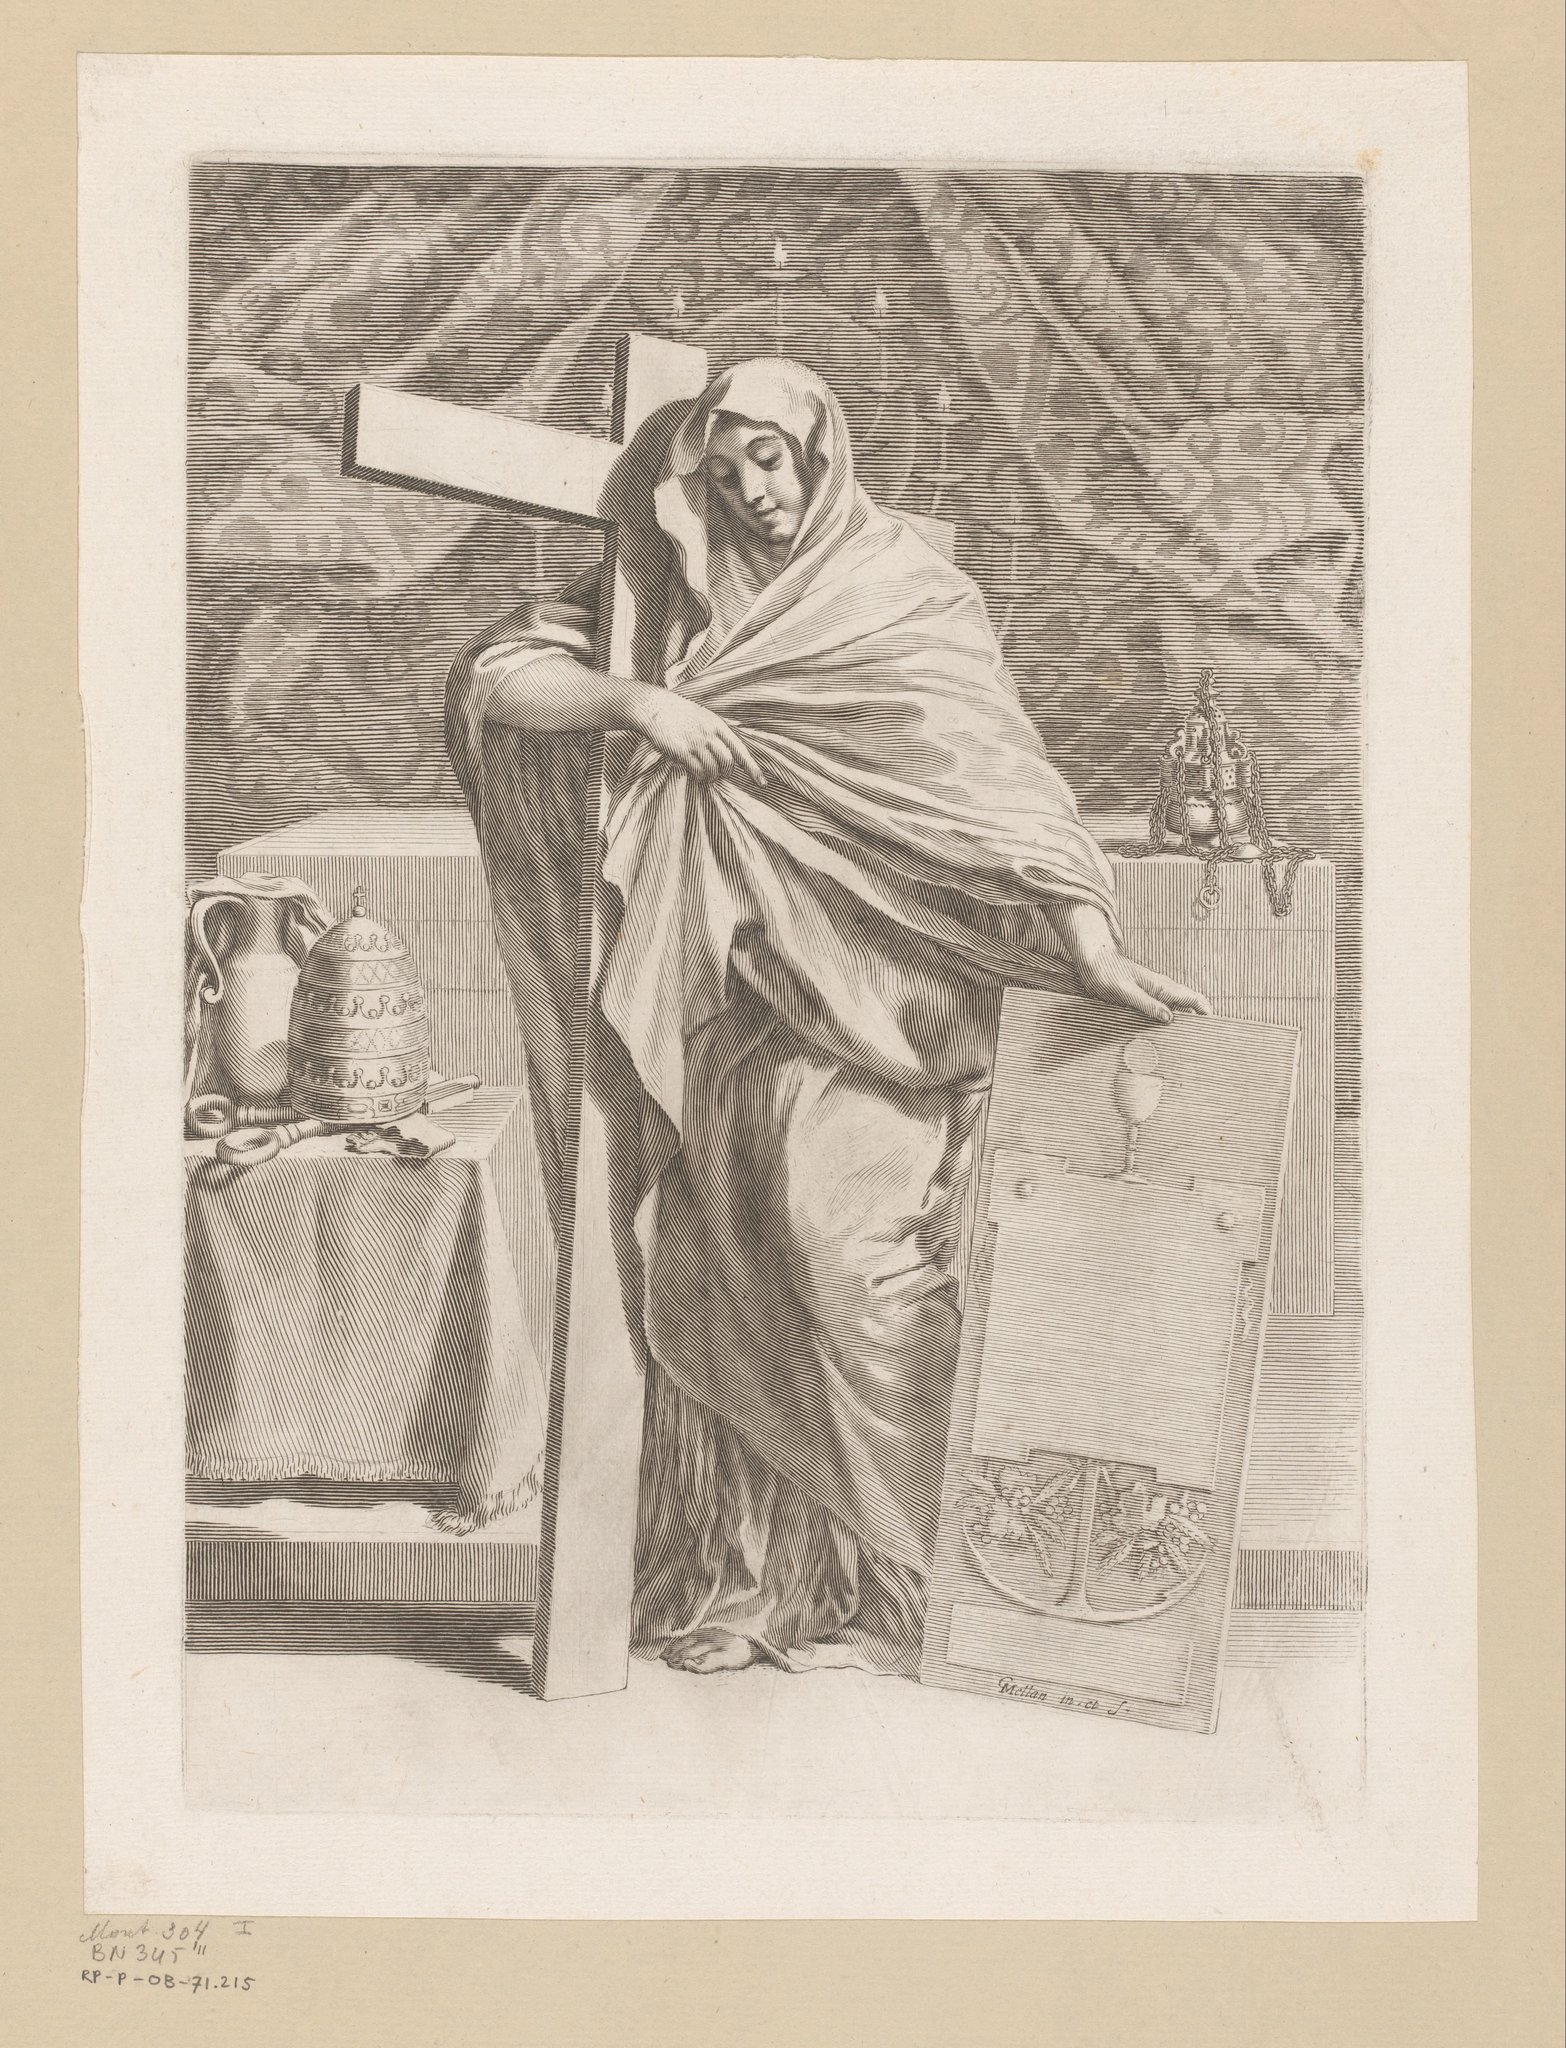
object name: titelblad, titelpagina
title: Titelpagina voor: Armand-Jean du Plessis hertog van Richelieu, Les Principaux points de la foi de l'Eglise catholique (...), 1642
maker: claude mellan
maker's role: draughtsman, print maker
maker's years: 1598-1688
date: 1642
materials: paper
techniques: engraving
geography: paris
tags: faith, 'fides'; 'fede', 'fede catholica', 'fede christiana', 'fede christiana catholica' (ripa) ~ one of the three theological virtues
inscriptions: collector's mark: Lugt 240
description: Titelpagina voor: Richelieu, Armand-Jean du Plessis hertog van. Les Principaux poincts de la foy catholique défendus contre contre l'escrit adressé au Roy par les ministres de Charenton. Parijs: Imprimerie Royale, 1642.